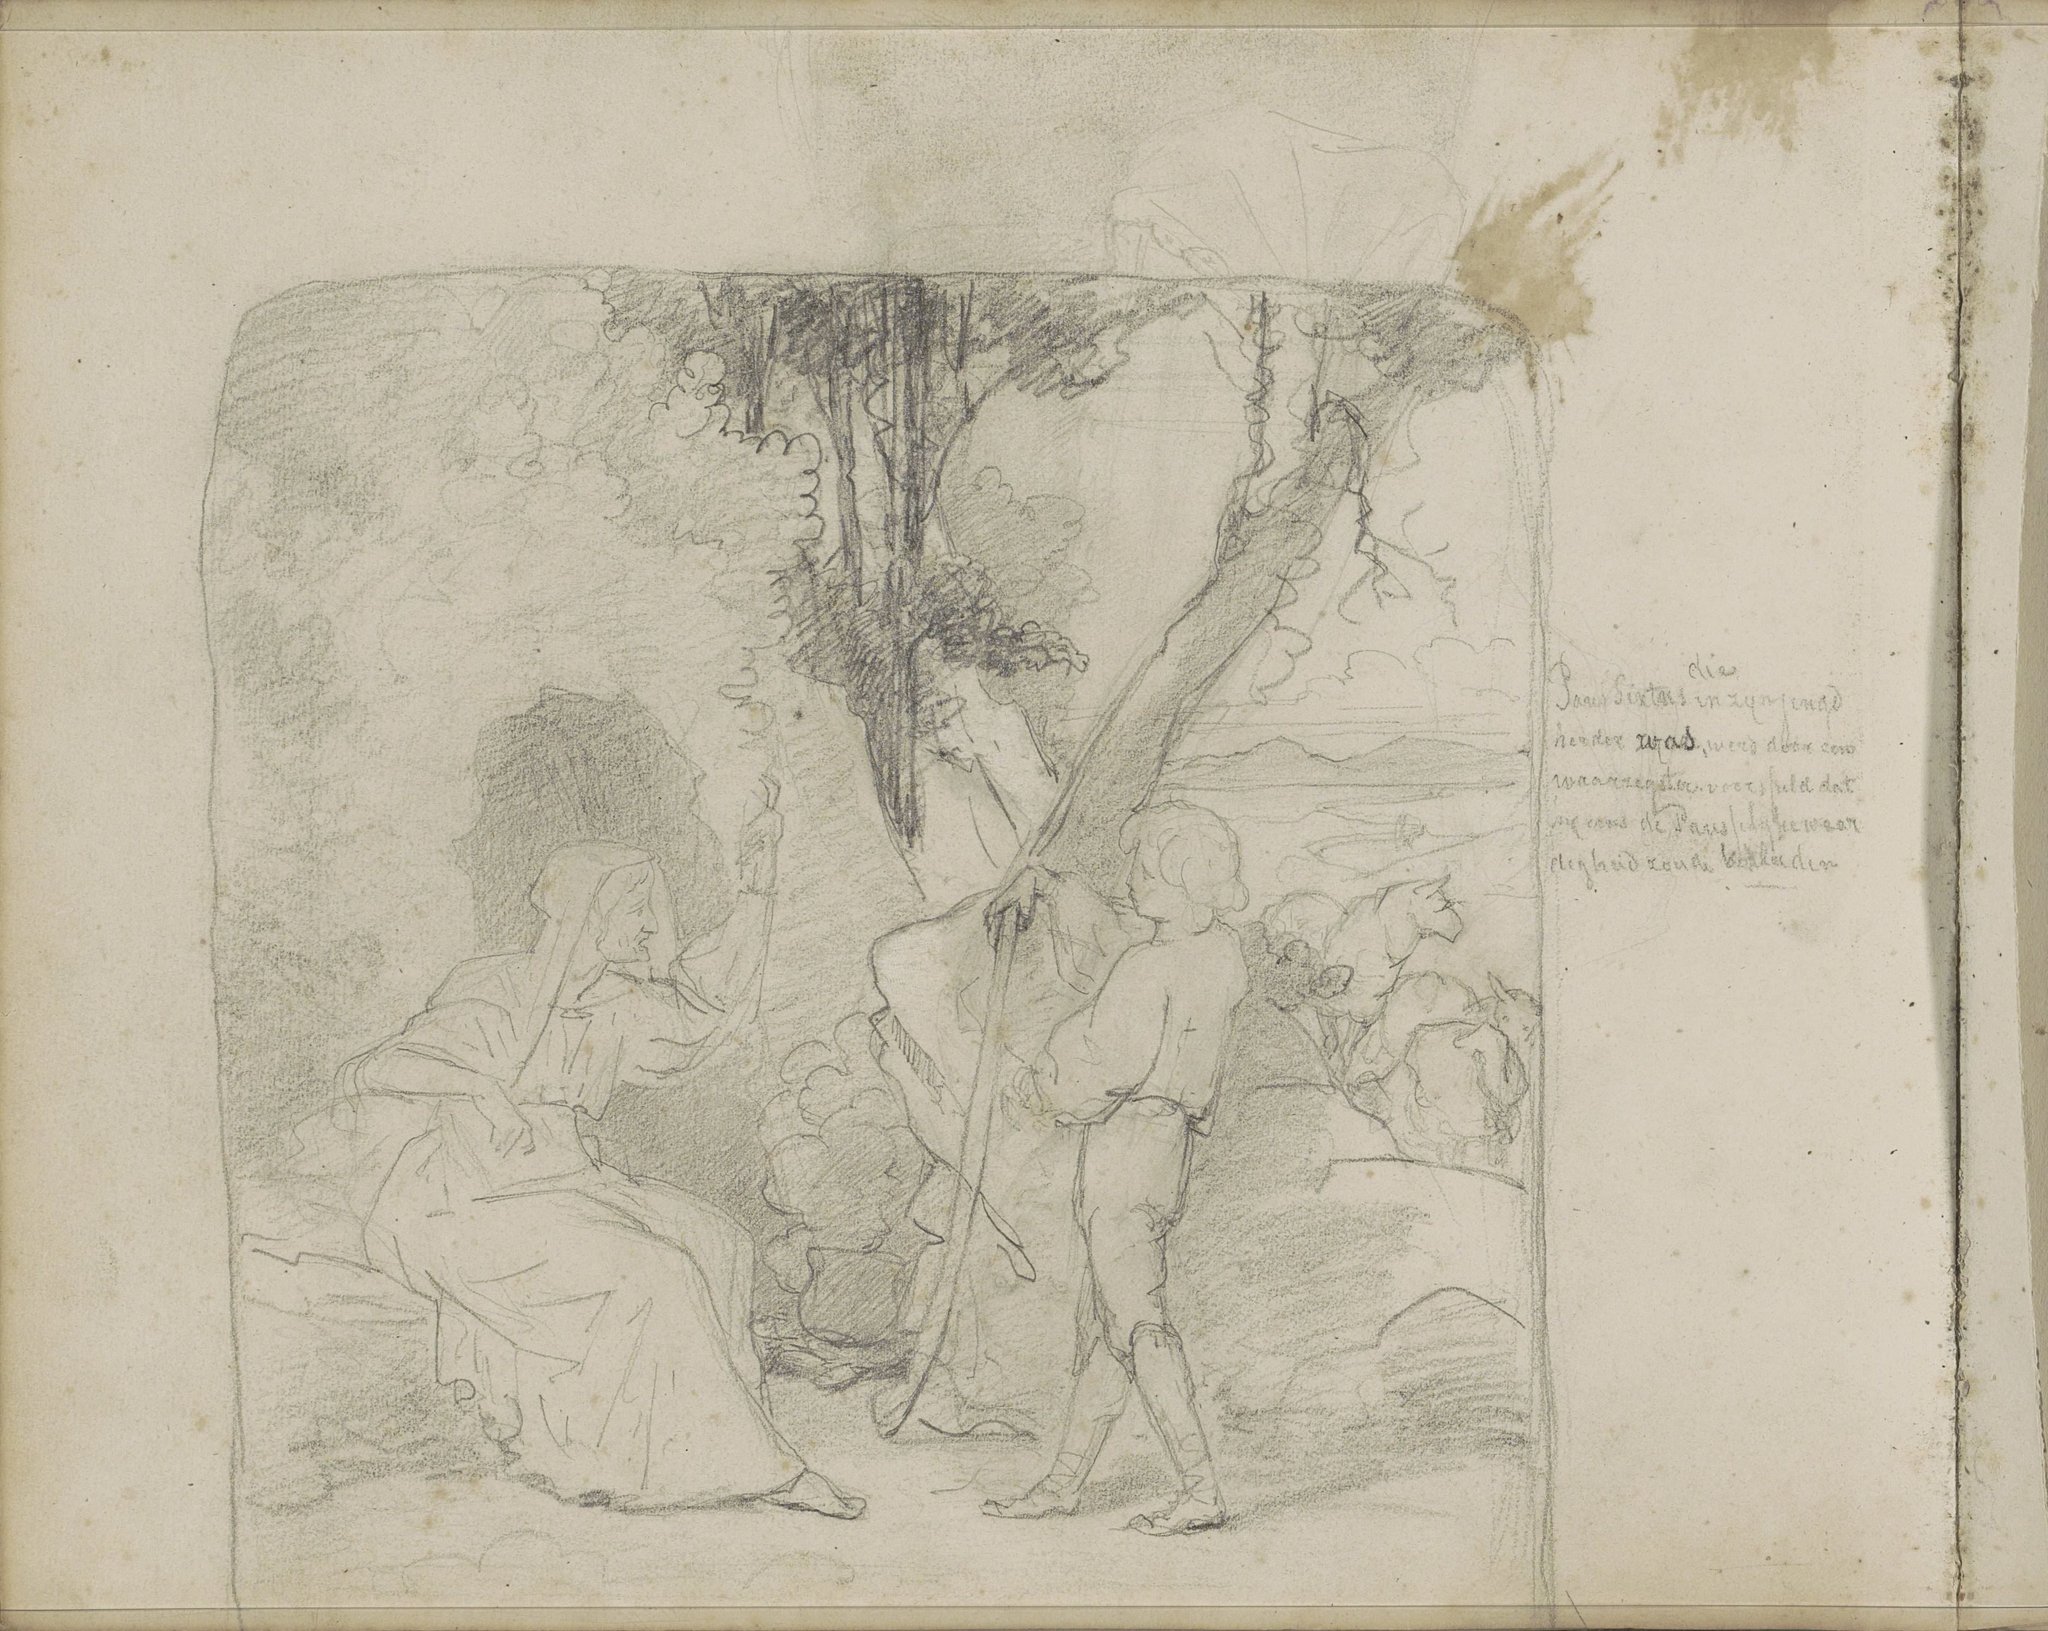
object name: sketchbook leaf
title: Herdersjongen Paris bij de waarzegster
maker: gerrit postma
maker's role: draughtsman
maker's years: 1819-1894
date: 1829-1894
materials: paper, pencil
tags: herd, flock, (story of) paris (alexander)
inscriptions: annotation: ‘Paris Sixt[...]s die in zijn jeugd/ herder was, werd door een/ waarzegster, voorspeld dat/ hij eens de Paris gelijke waar/ digheid zoude be[...]den’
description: Op de achtergrond staat een kudde koeien. Tekening in een kader. Blad 34 verso uit een schetsboek met 35 bladen.